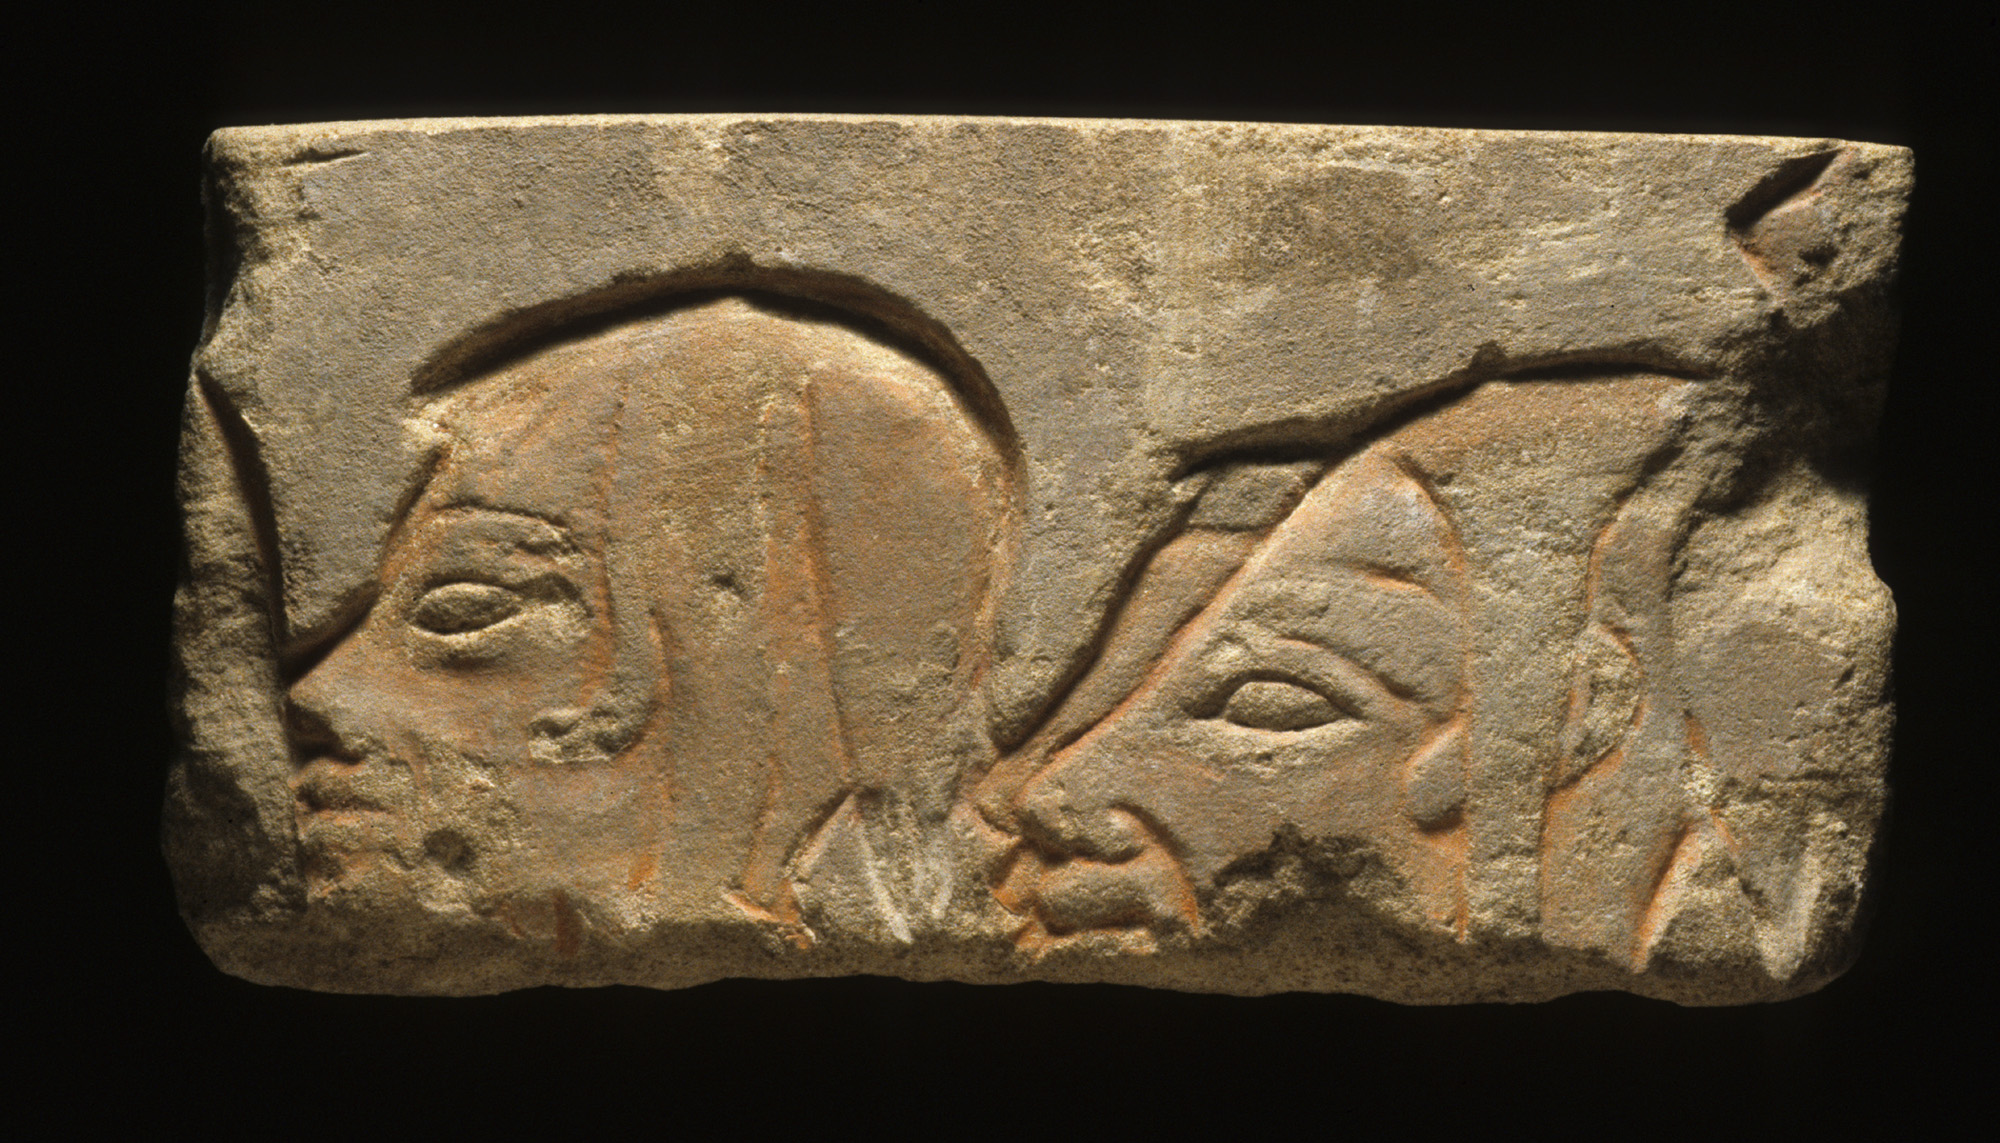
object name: relief, three libyan head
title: Relief block with the heads of three Libyans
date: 1353-1323 BCE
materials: paint, stone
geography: egypt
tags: heads,men